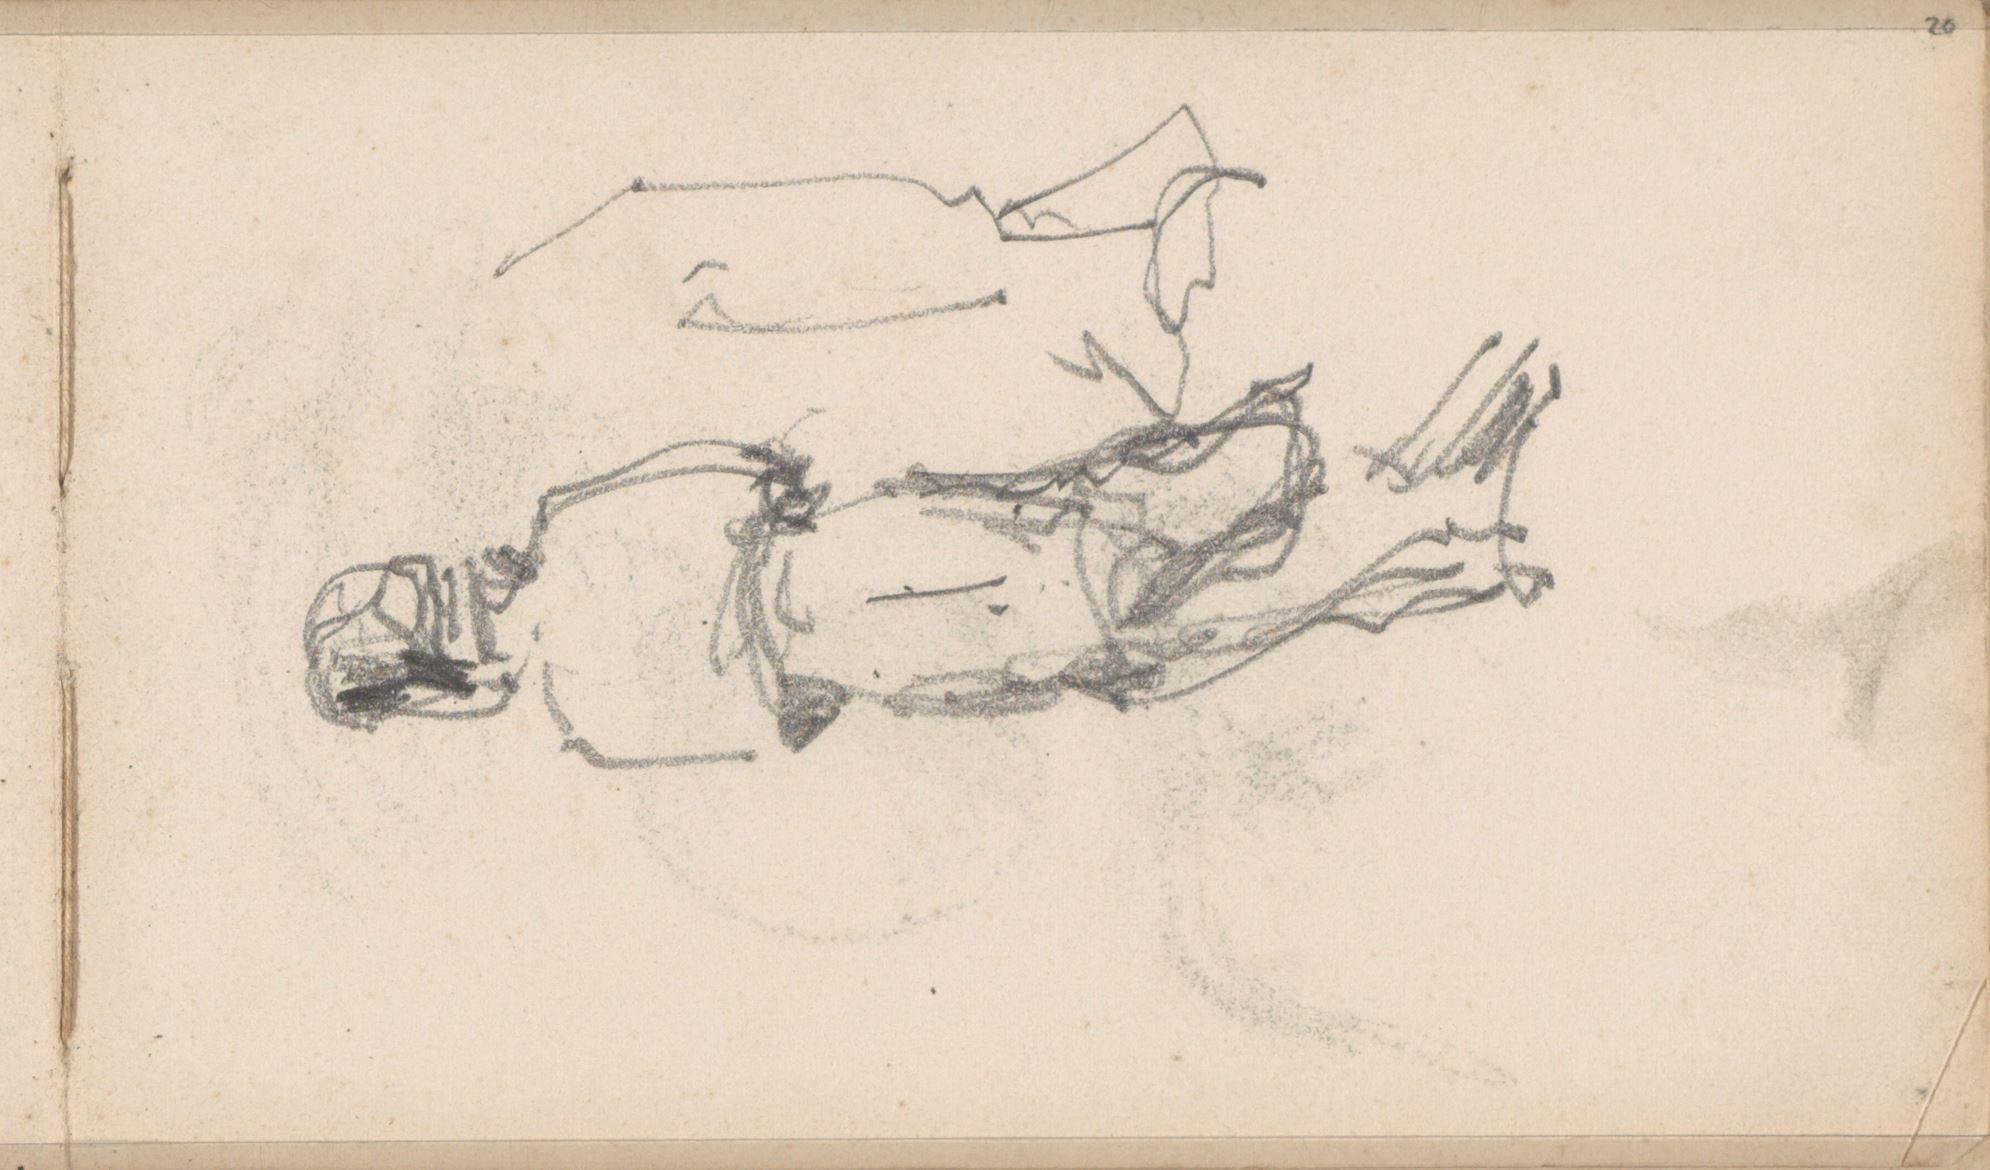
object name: sketchbook leaf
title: Staande vrouw, op de rug gezien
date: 1881-1883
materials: paper, pencil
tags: standing figure - aa - female human figure (+ back view)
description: Pagina 20 uit een schetsboek met 30 bladen.